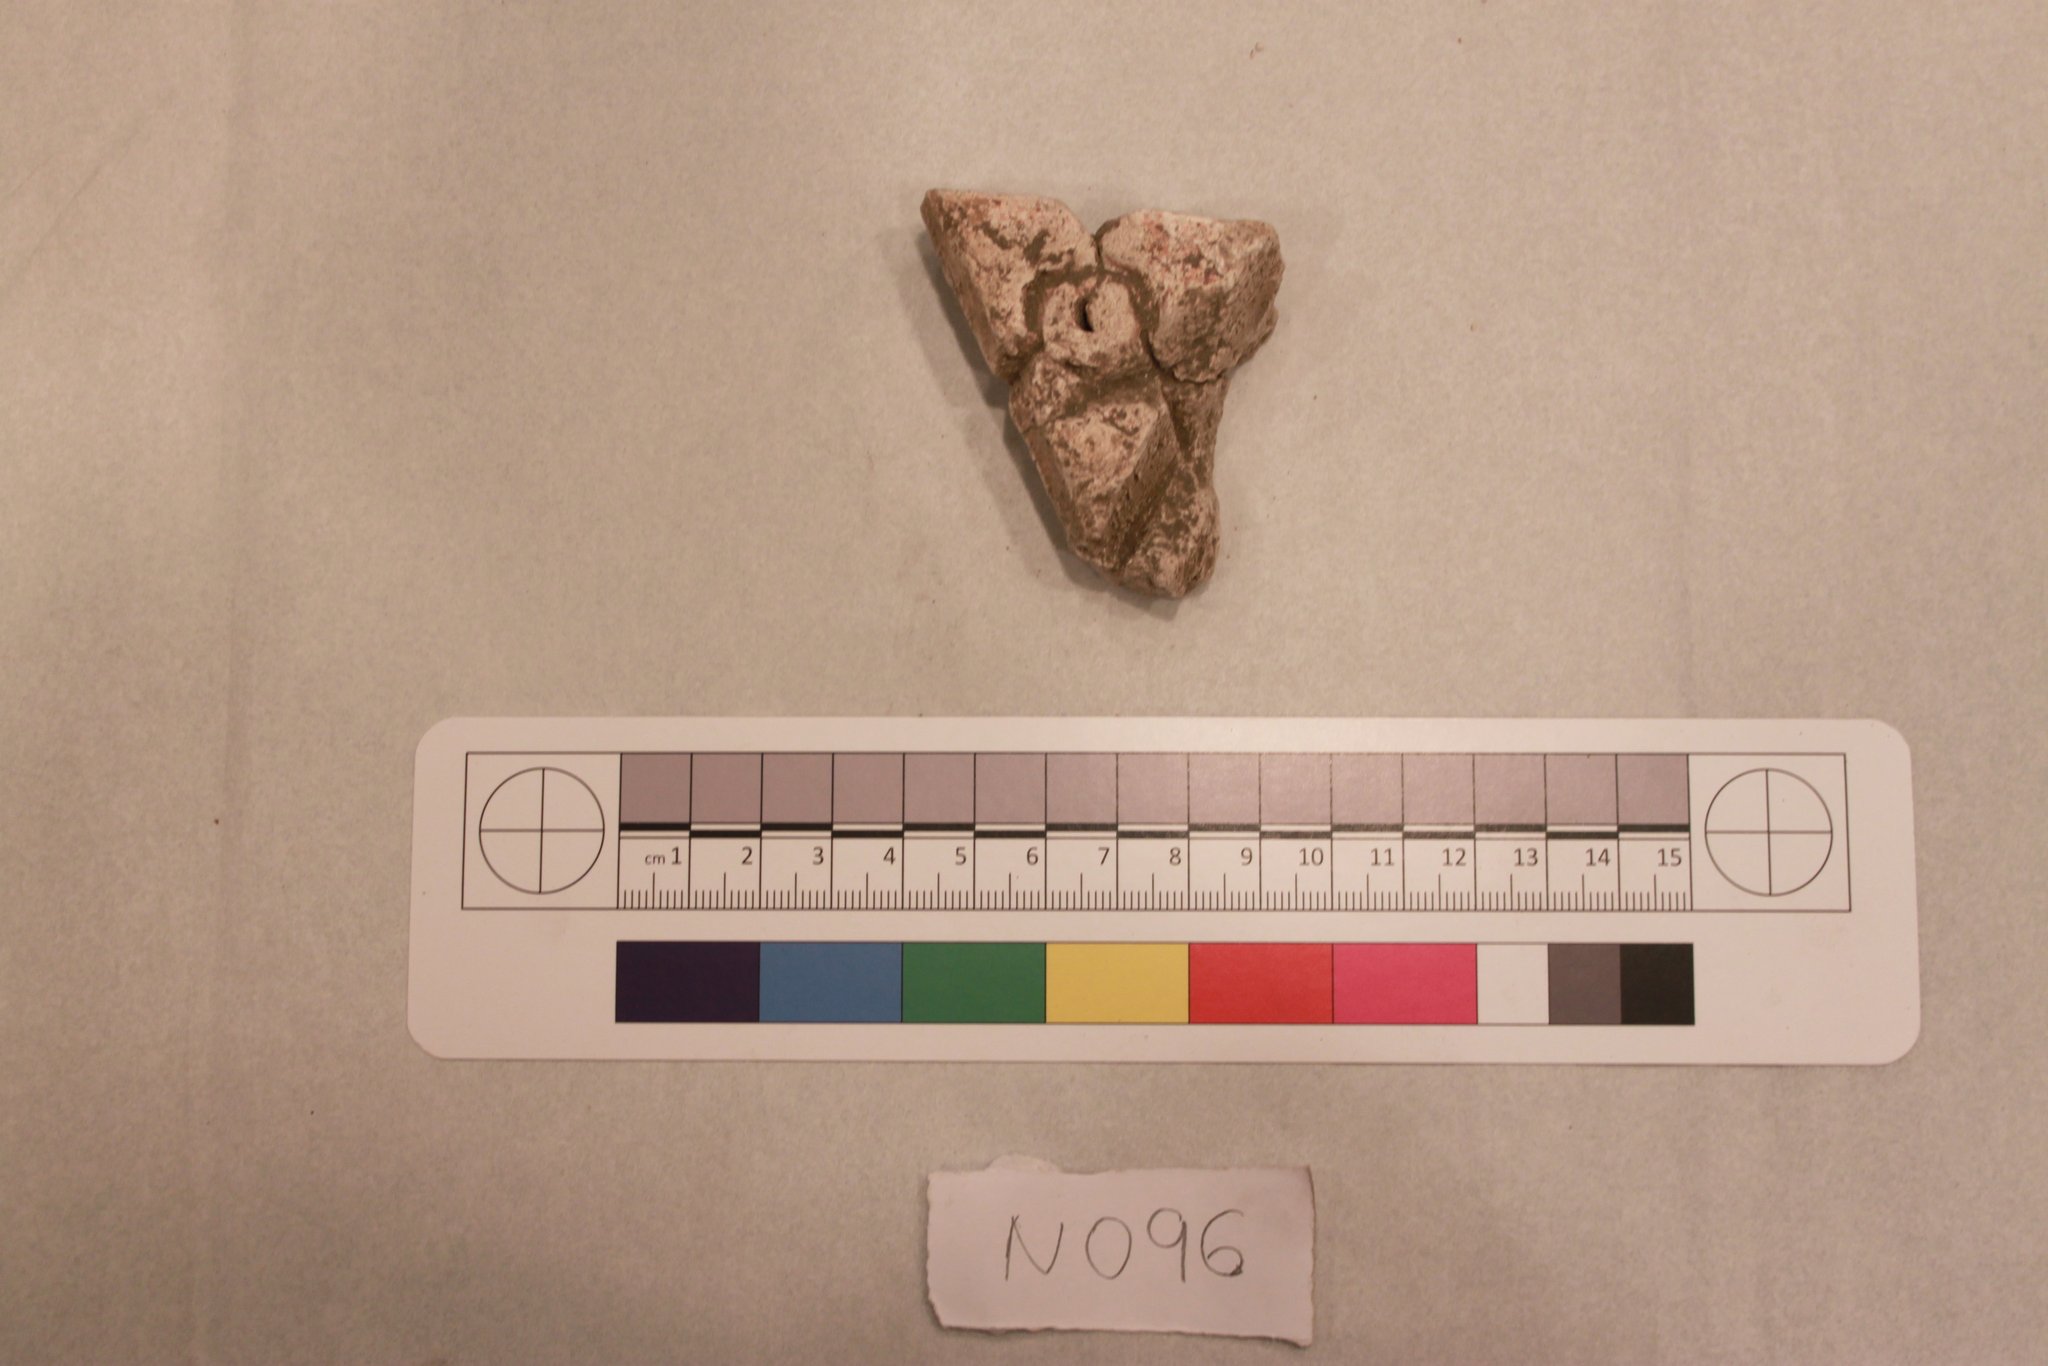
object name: fragment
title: Stucco Fragment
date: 701-1200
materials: plaster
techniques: carving, painting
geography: iran